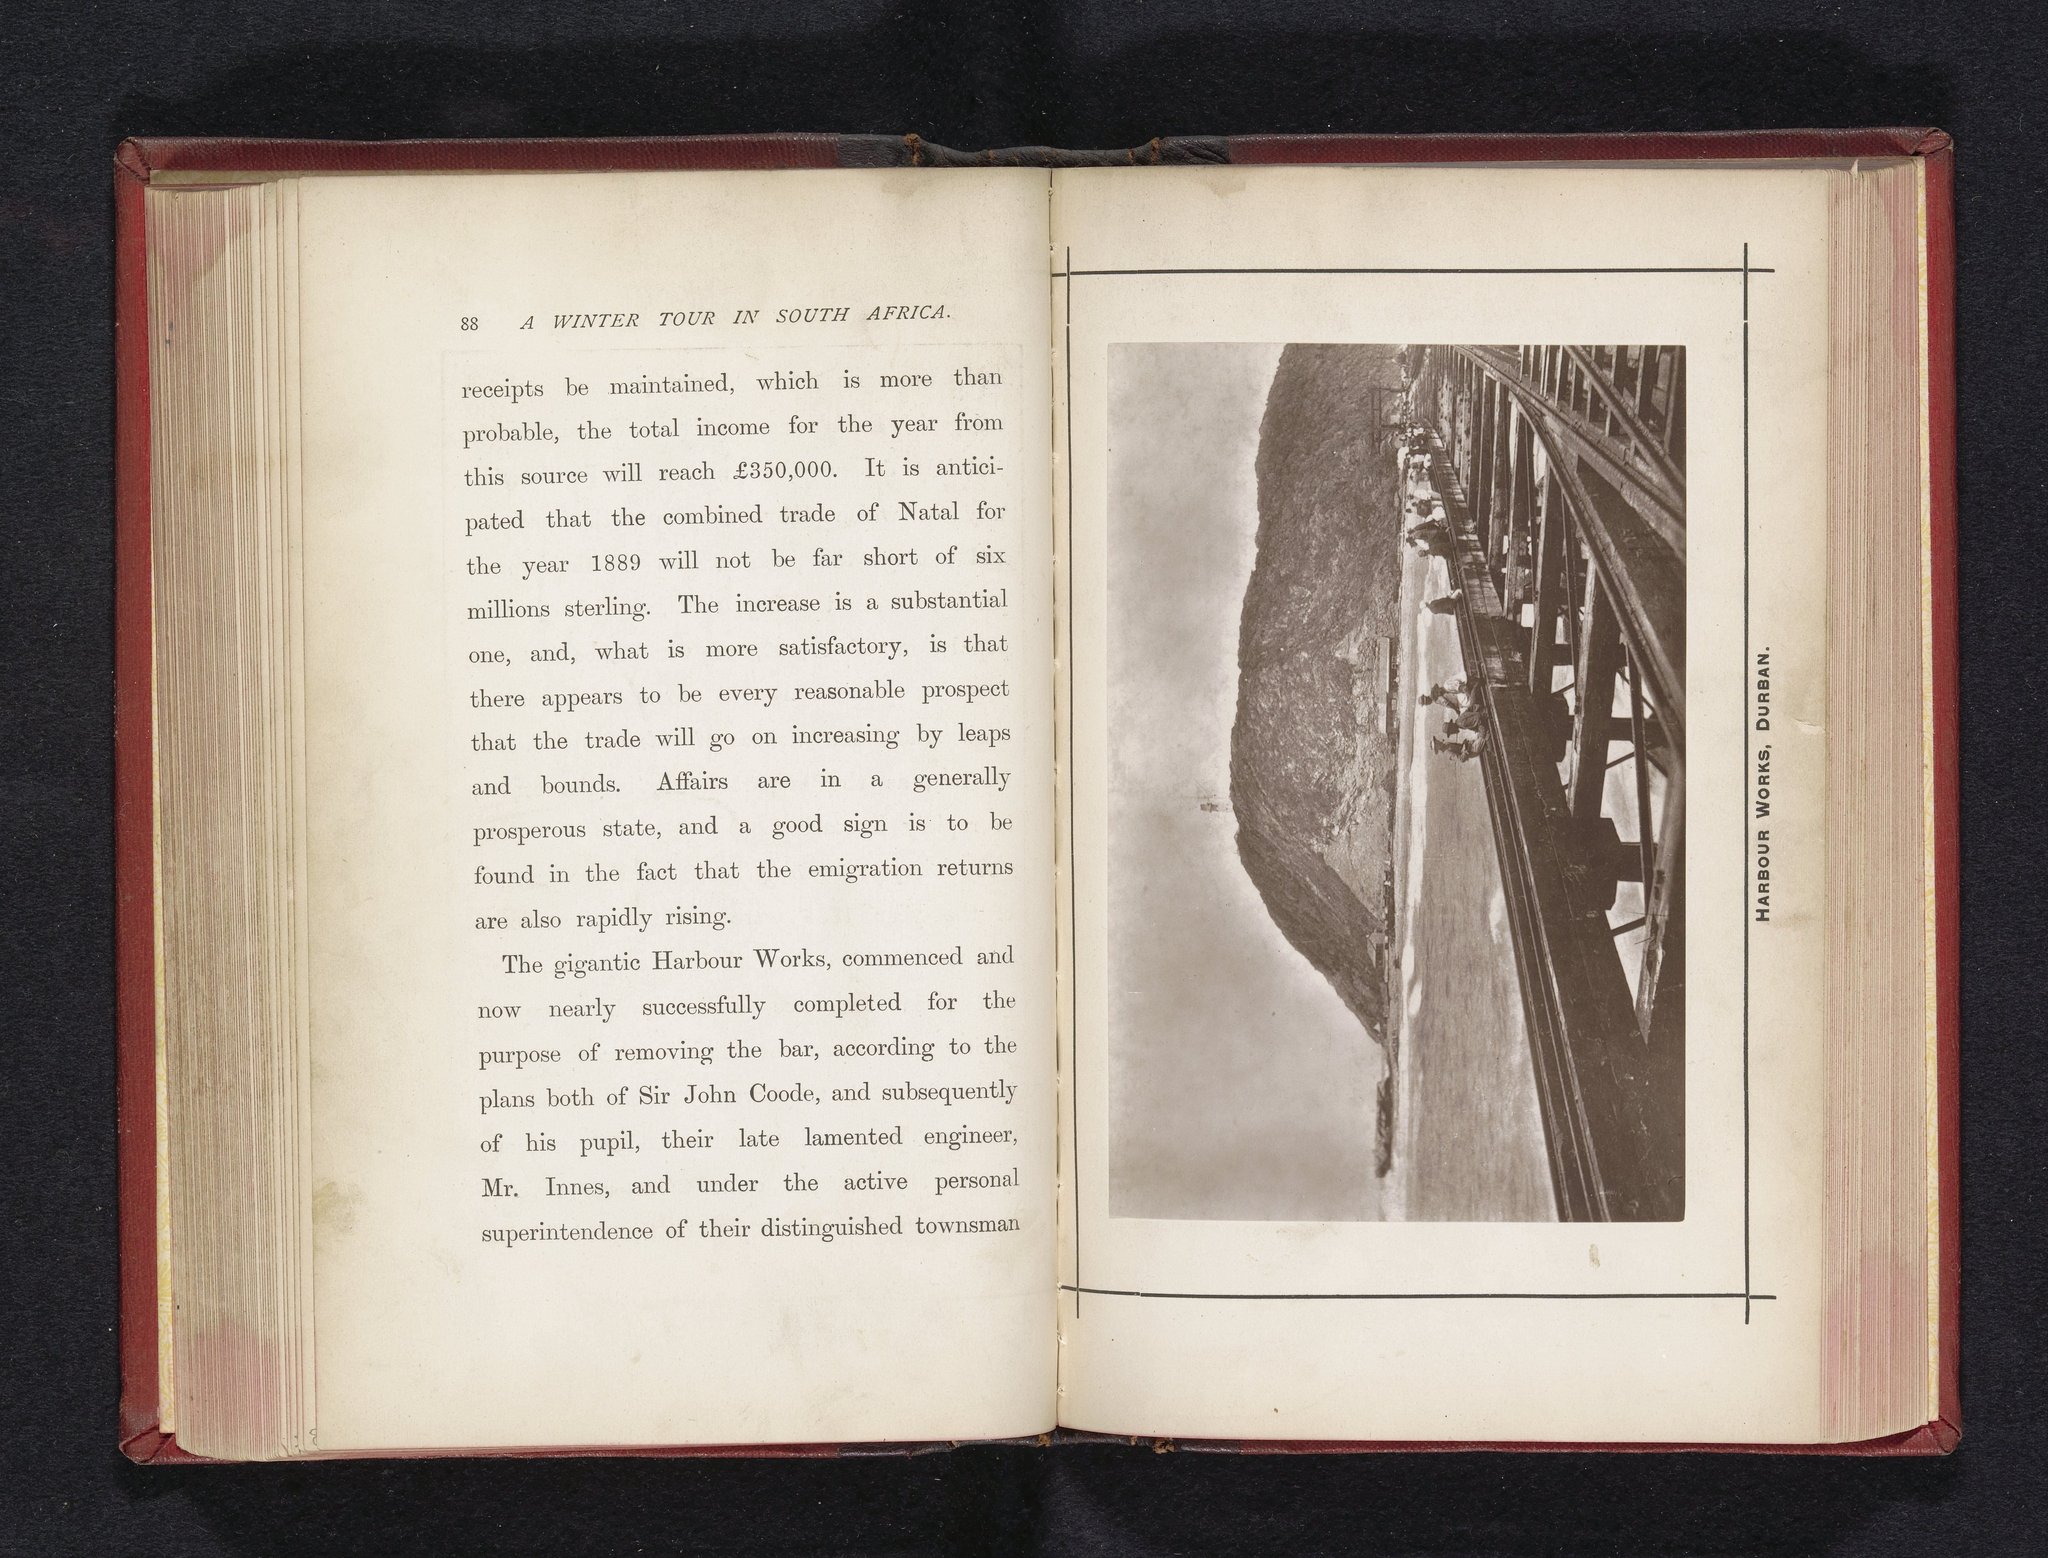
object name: photomechanical print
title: Harbour Works, Durban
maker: Anonymous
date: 1888-1890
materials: paper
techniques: woodburytype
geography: durban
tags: harbour, shipyard-workers